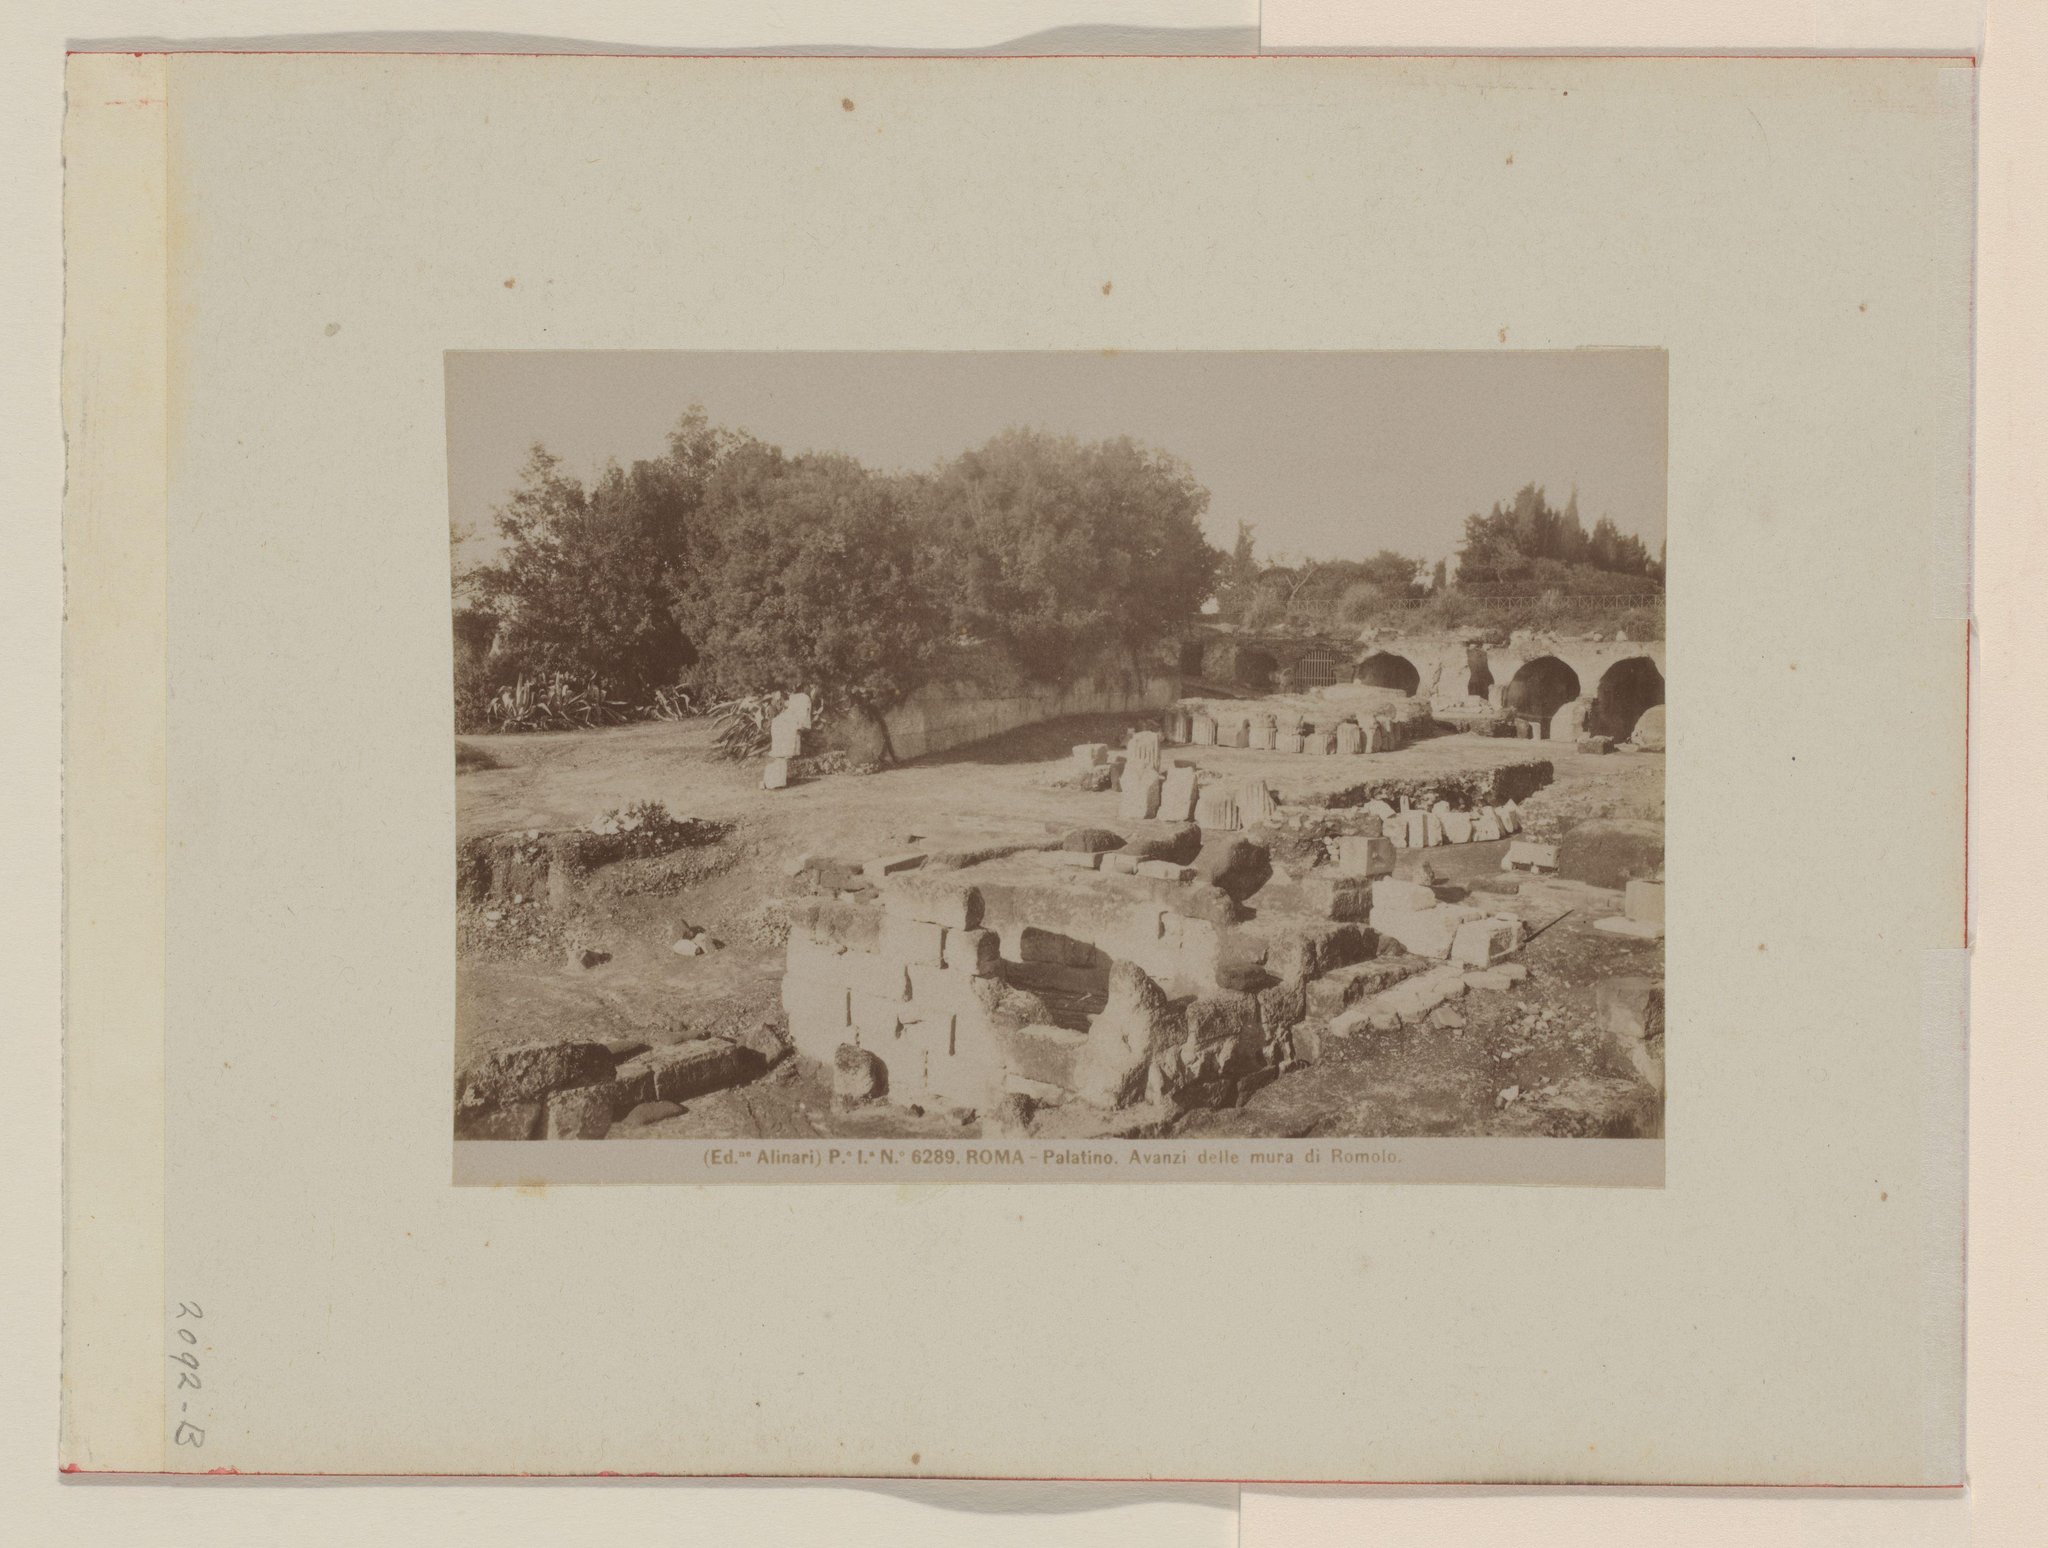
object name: photograph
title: Roma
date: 1857-1900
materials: cardboard, paper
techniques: albumen print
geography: rome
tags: landscape with ruins, walls ~ fortified city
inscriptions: number: ‘Po.Io.No. 6289.’